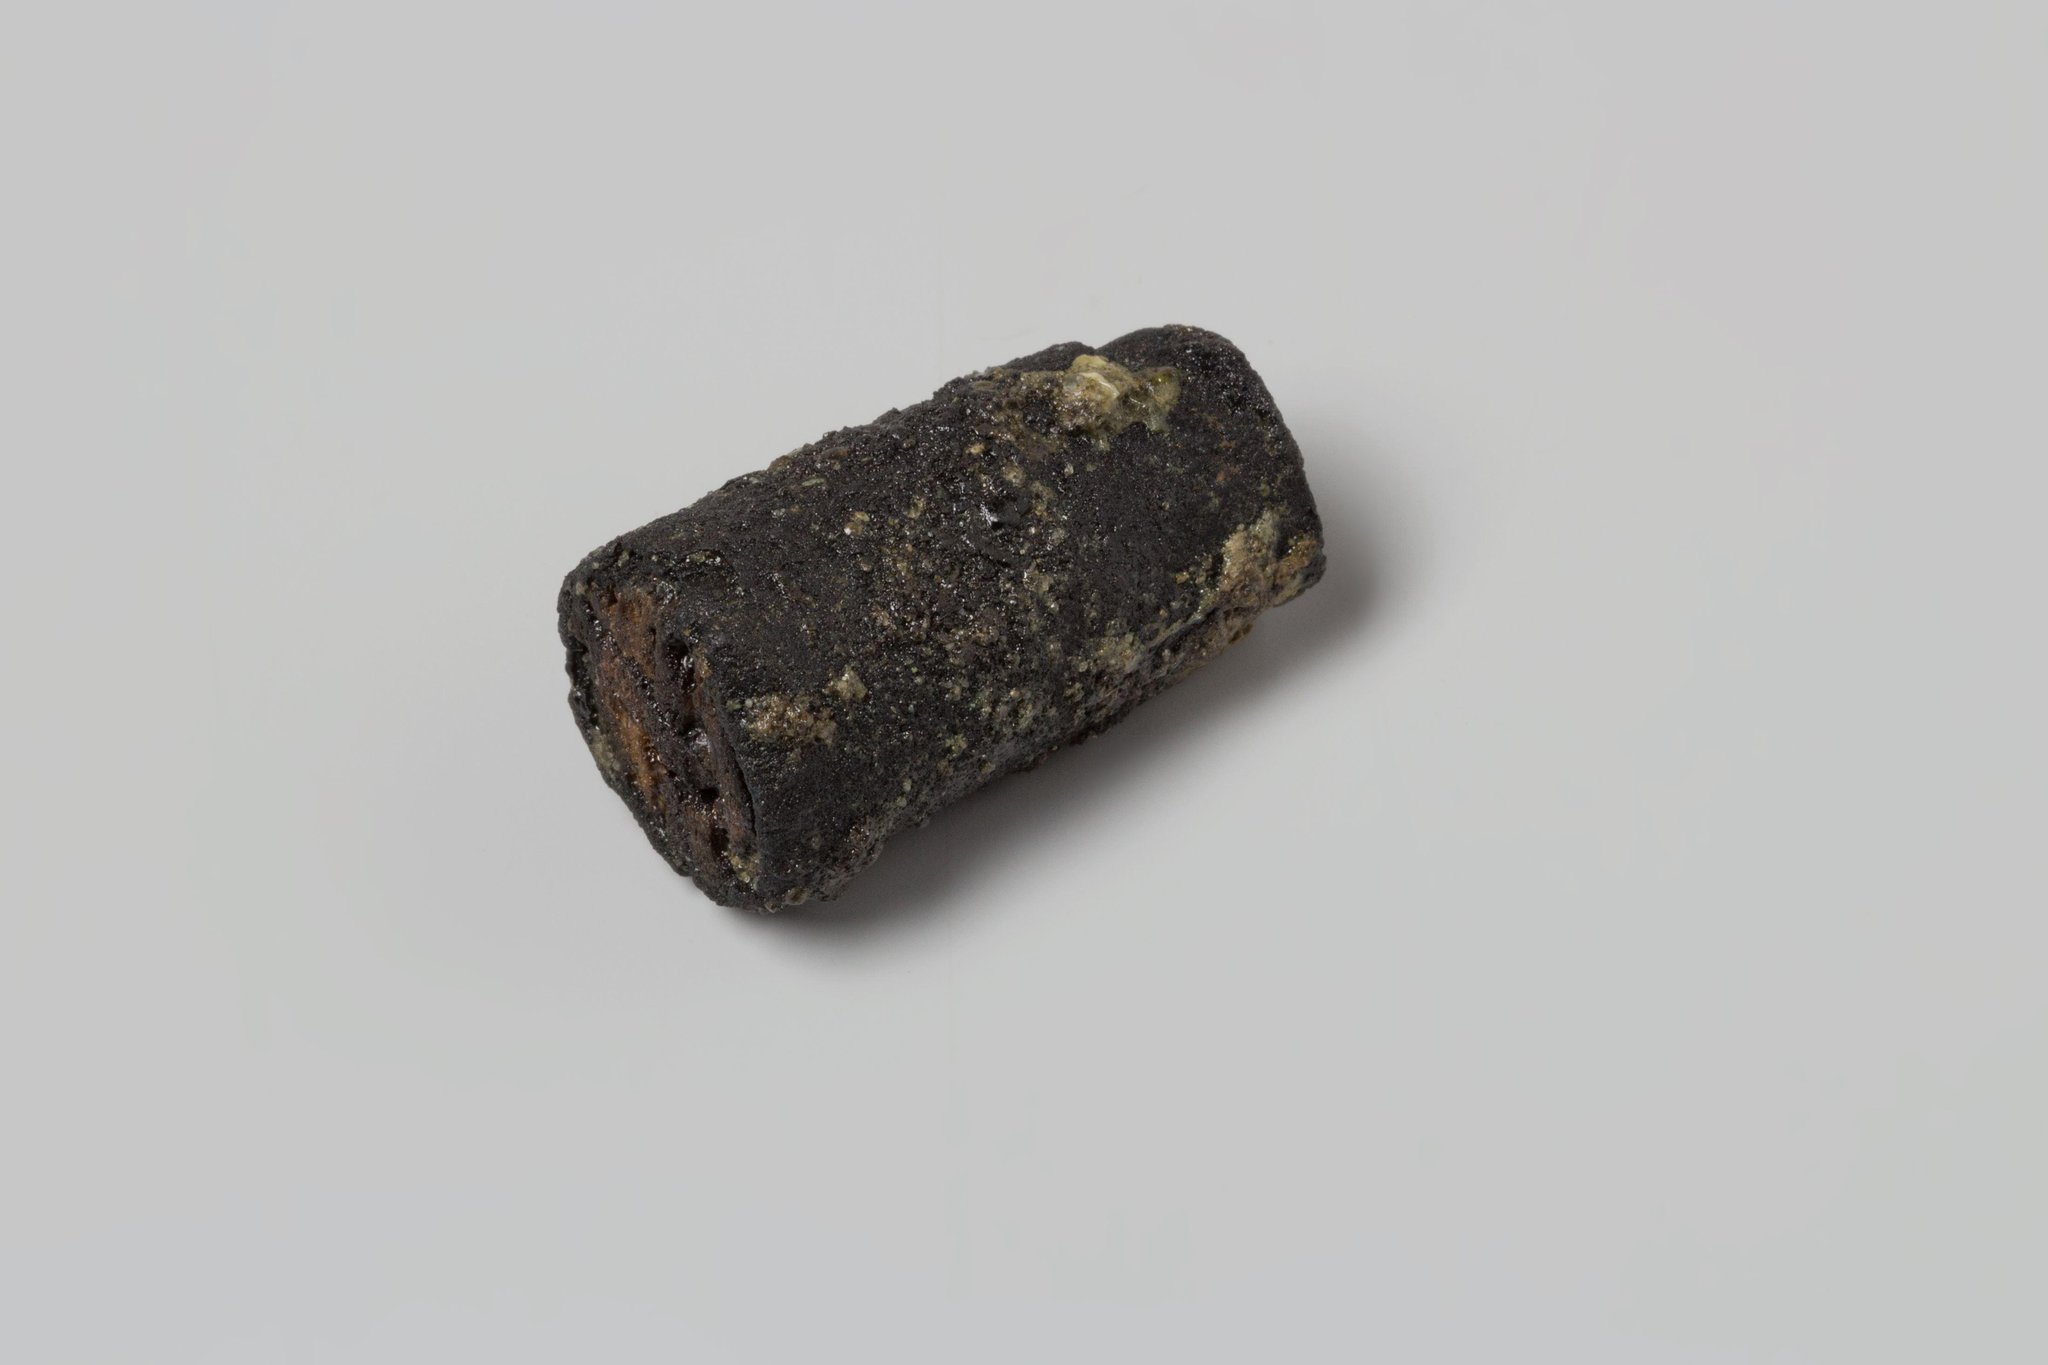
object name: cork stopper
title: Kurk van wijnfles uit het wrak van de Oost-Indiëvaarder 't Vliegend Hart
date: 1700-1735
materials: cork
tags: 't vliegend hart (schip), verenigde oostindische compagnie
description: De donkergrijs/zwarte kurk maakte vermoedelijk ooit onderdeel uit van een wijnfles. Cork.